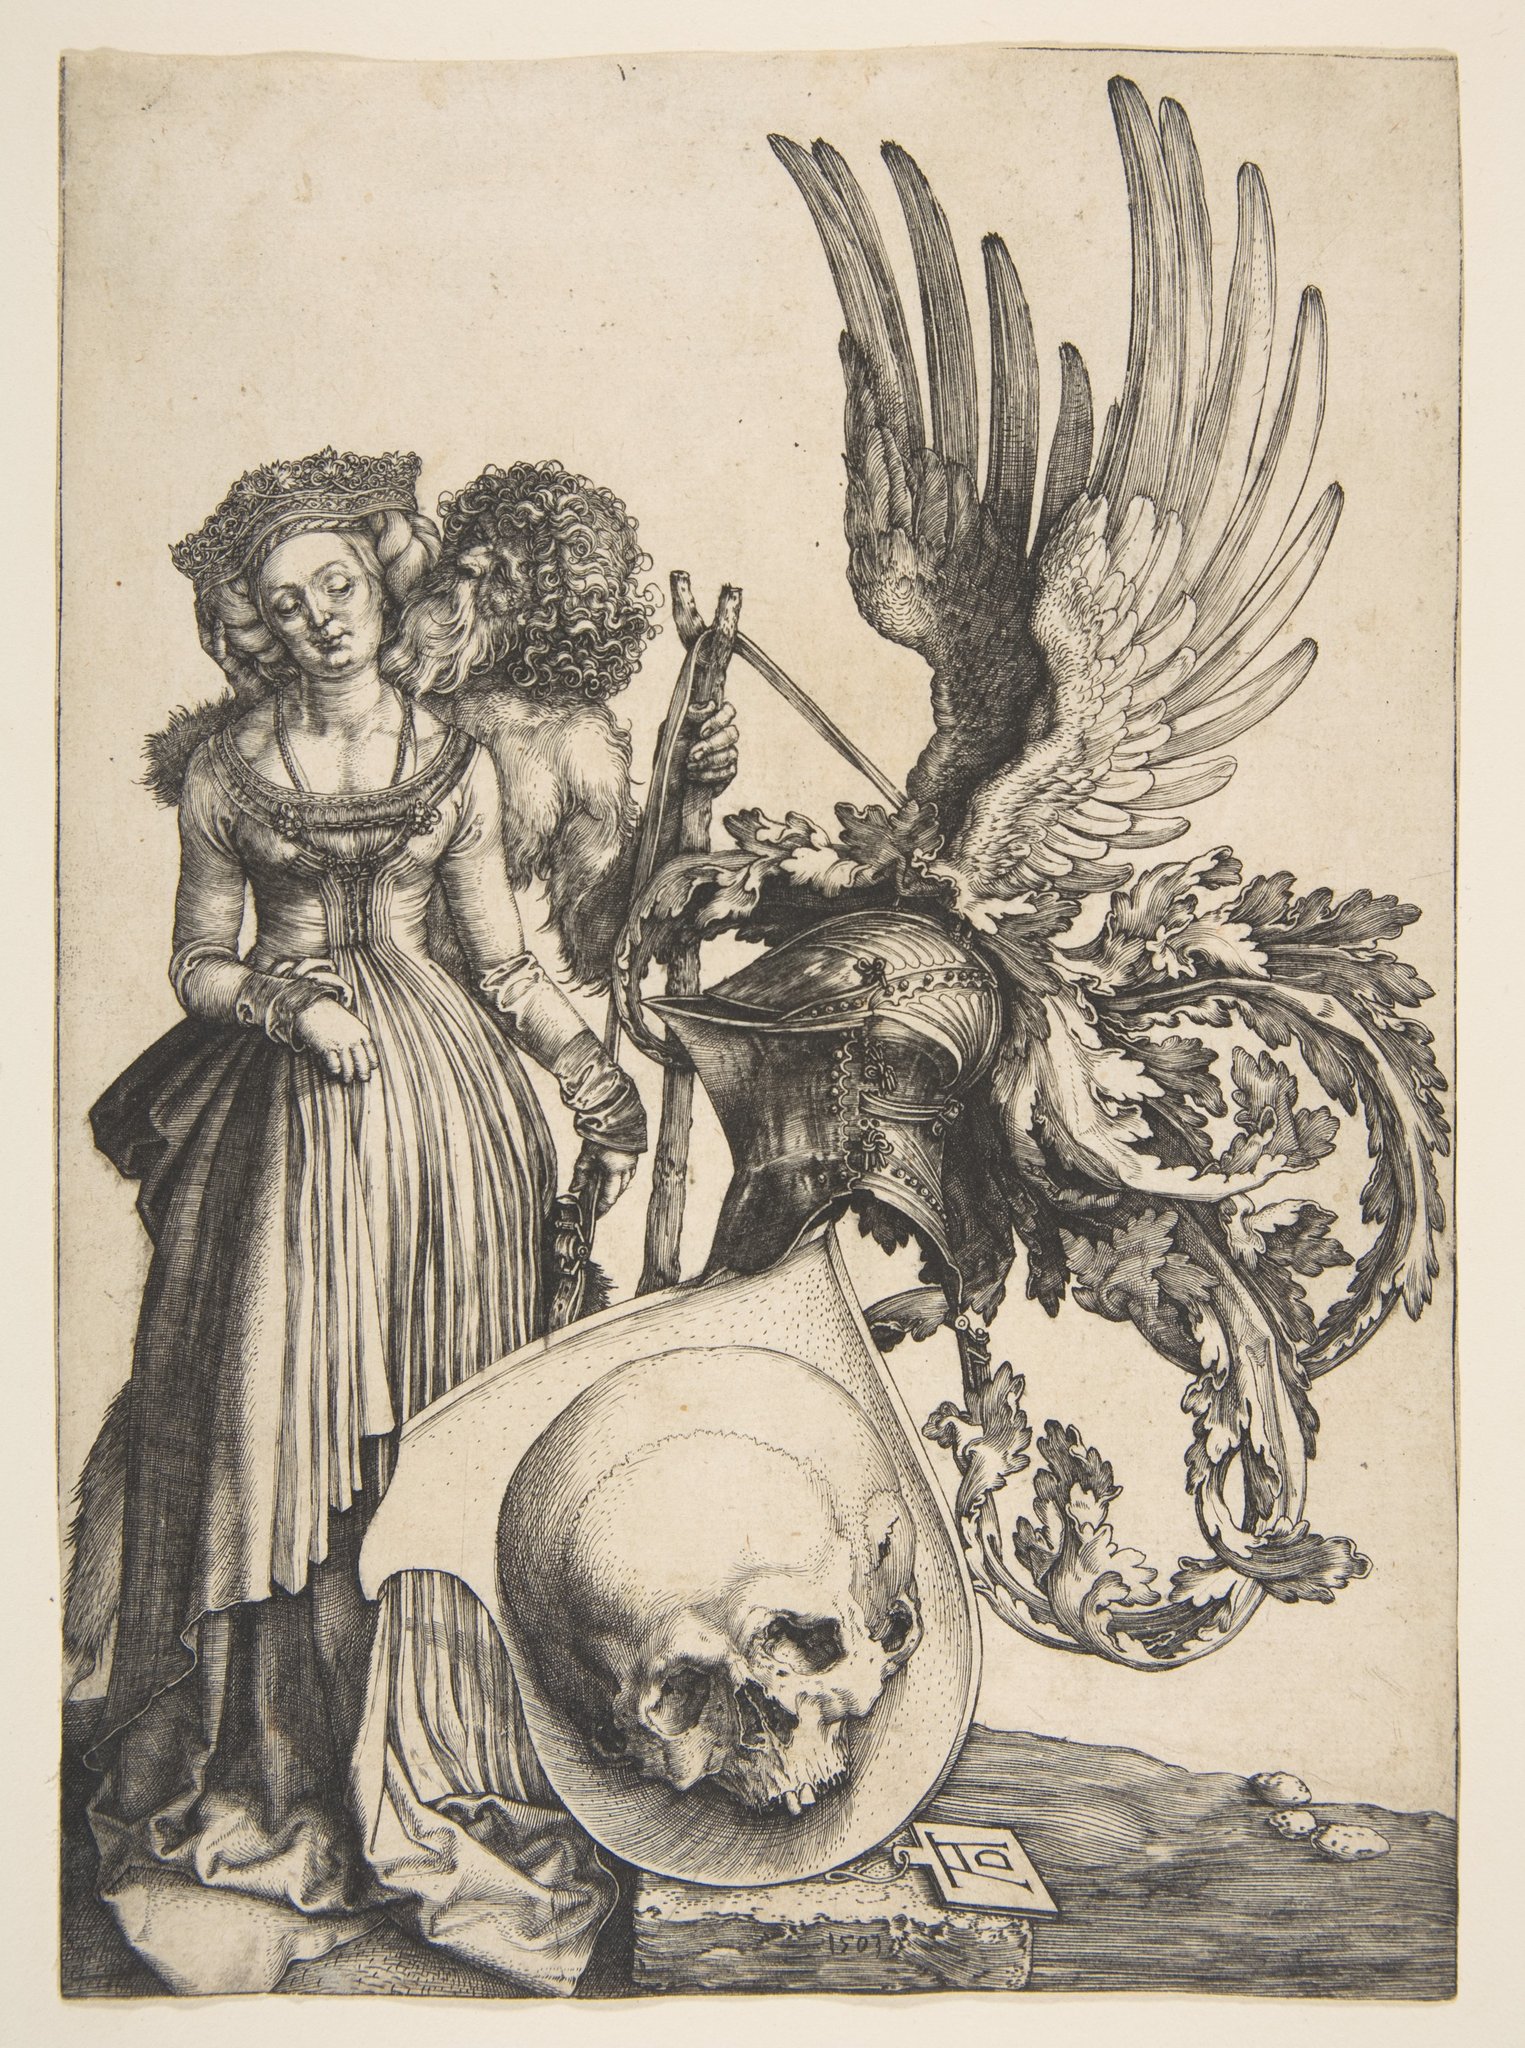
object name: print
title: Coat of Arms with a Skull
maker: albrecht dürer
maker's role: artist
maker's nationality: german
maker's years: 1471-1528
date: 1503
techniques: engraving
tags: skulls,men,women,coat of arms